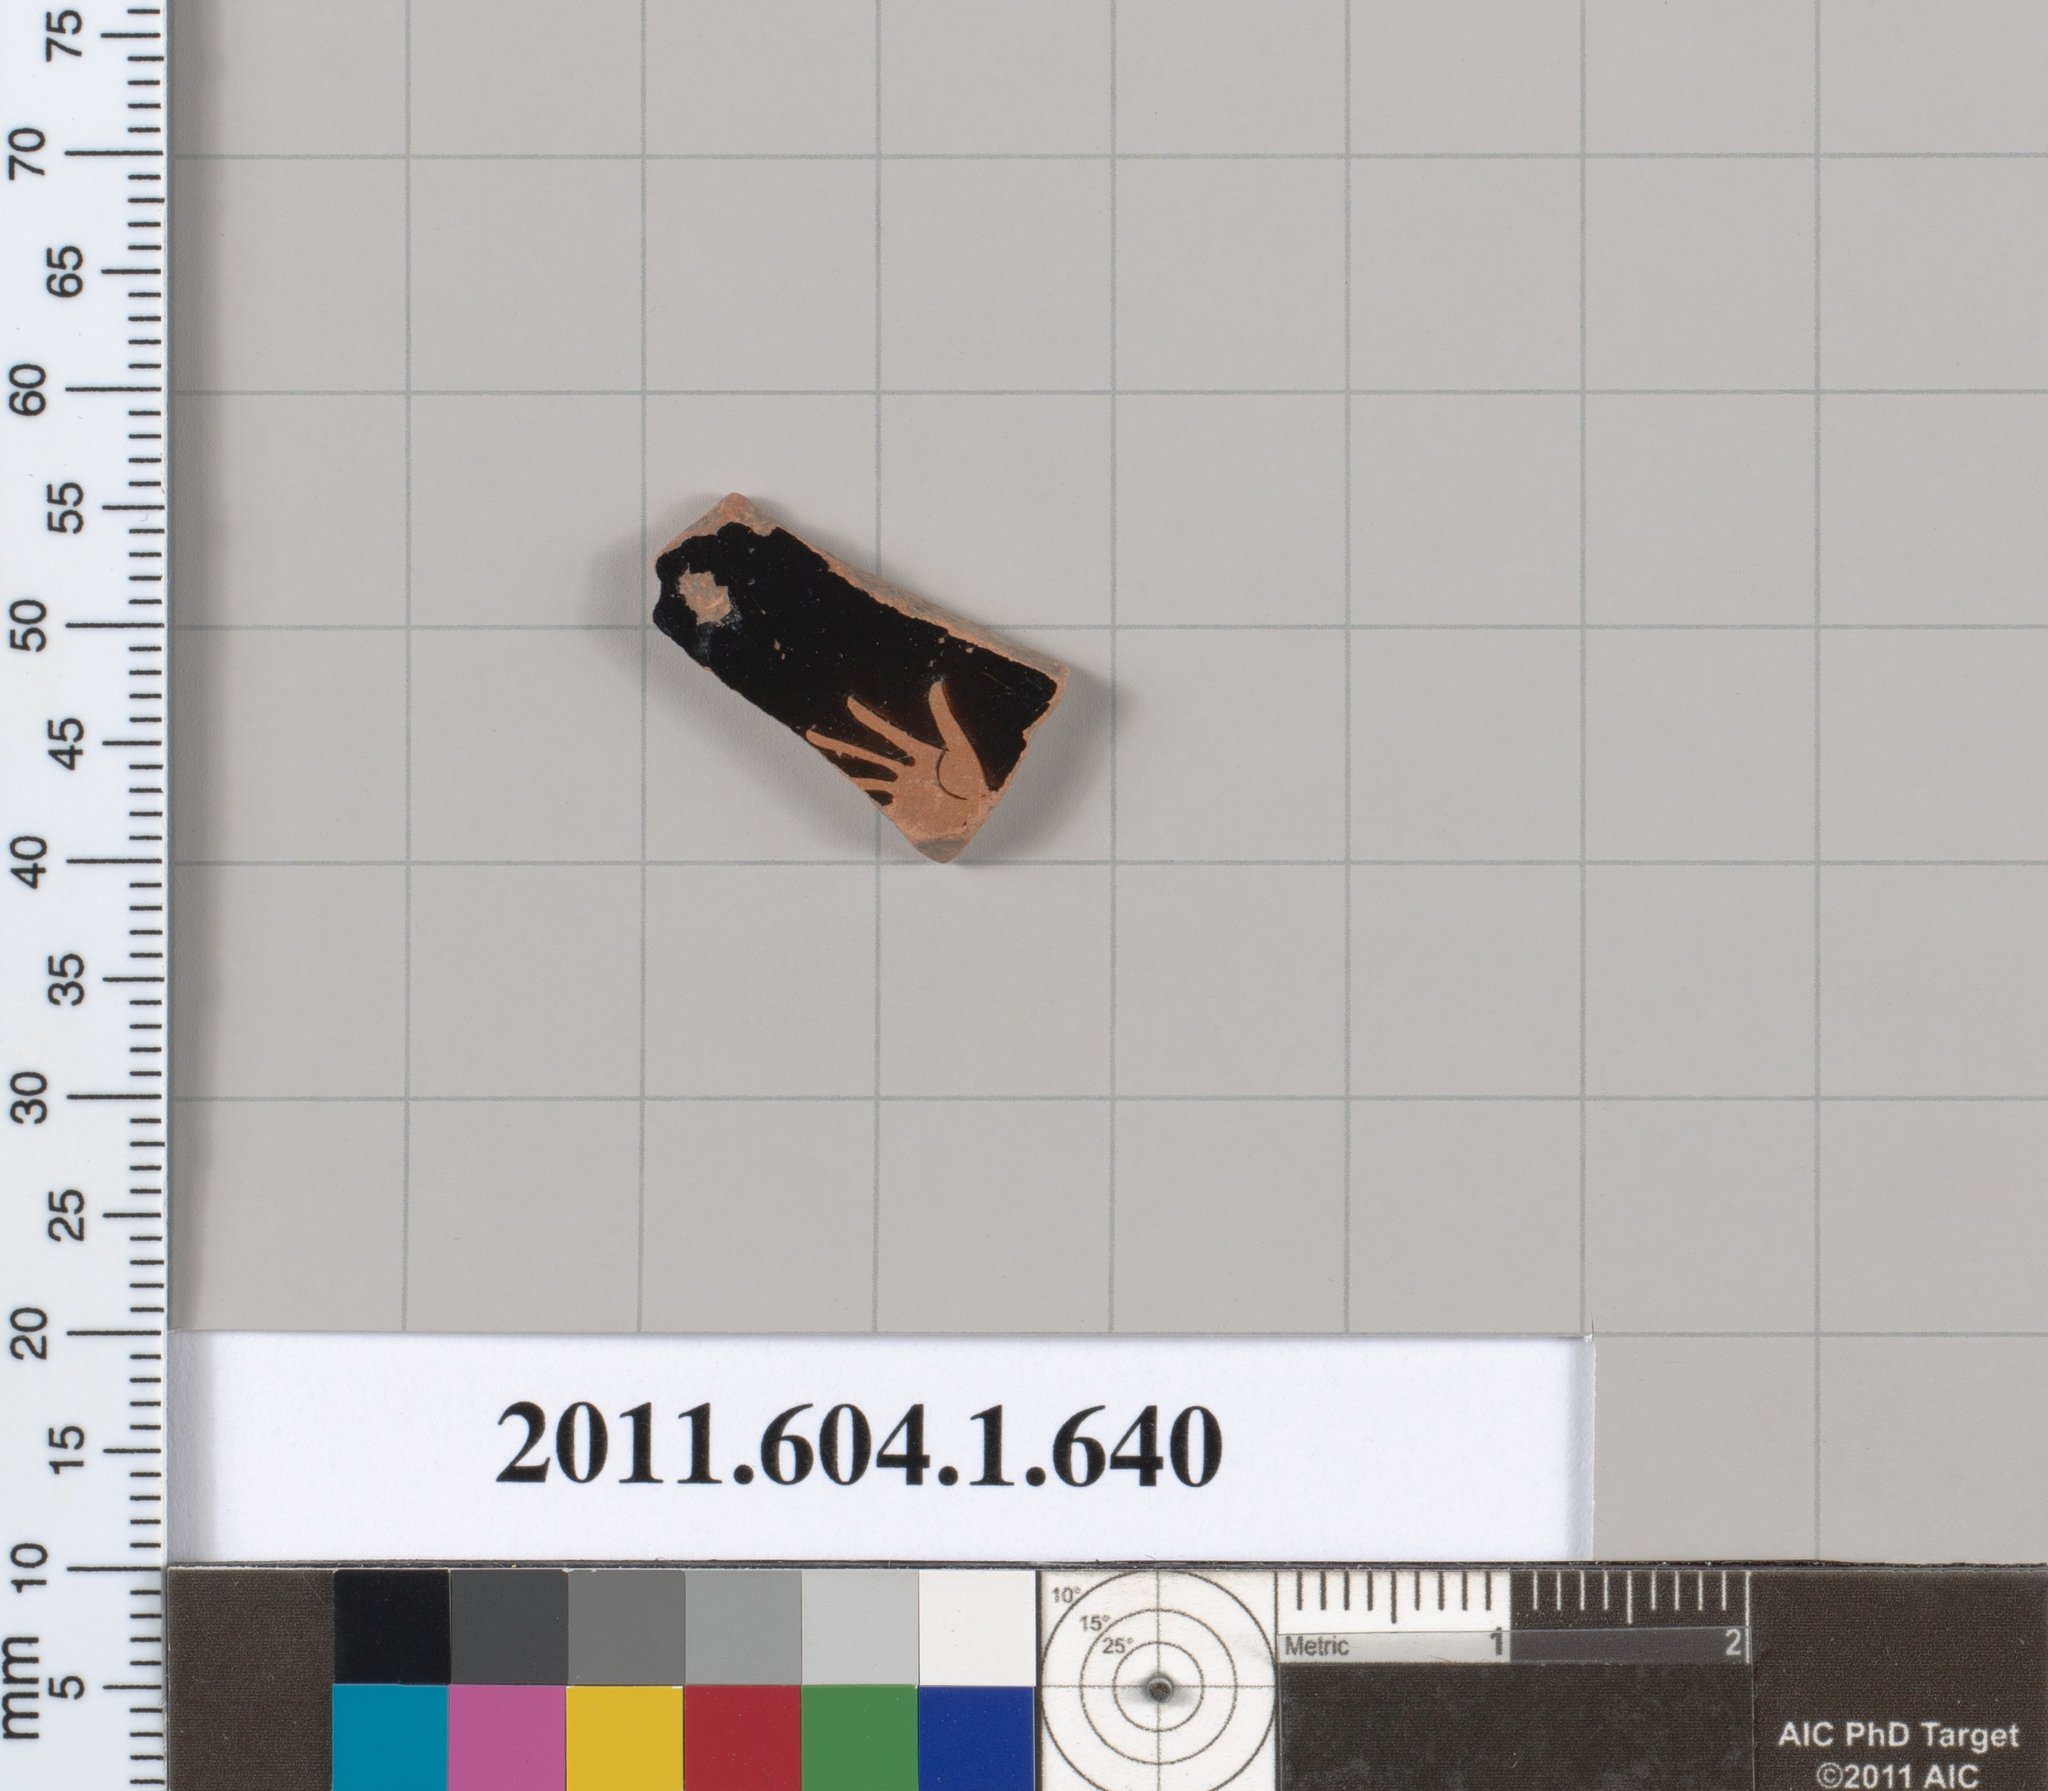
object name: kylix fragment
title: Terracotta fragment of a kylix (drinking cup)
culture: greek, attic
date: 475-451 BCE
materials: terracotta